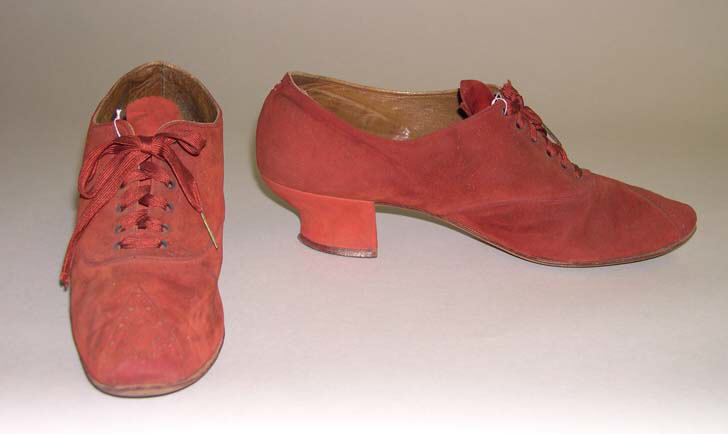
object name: oxford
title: Oxfords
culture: american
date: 1880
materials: leather